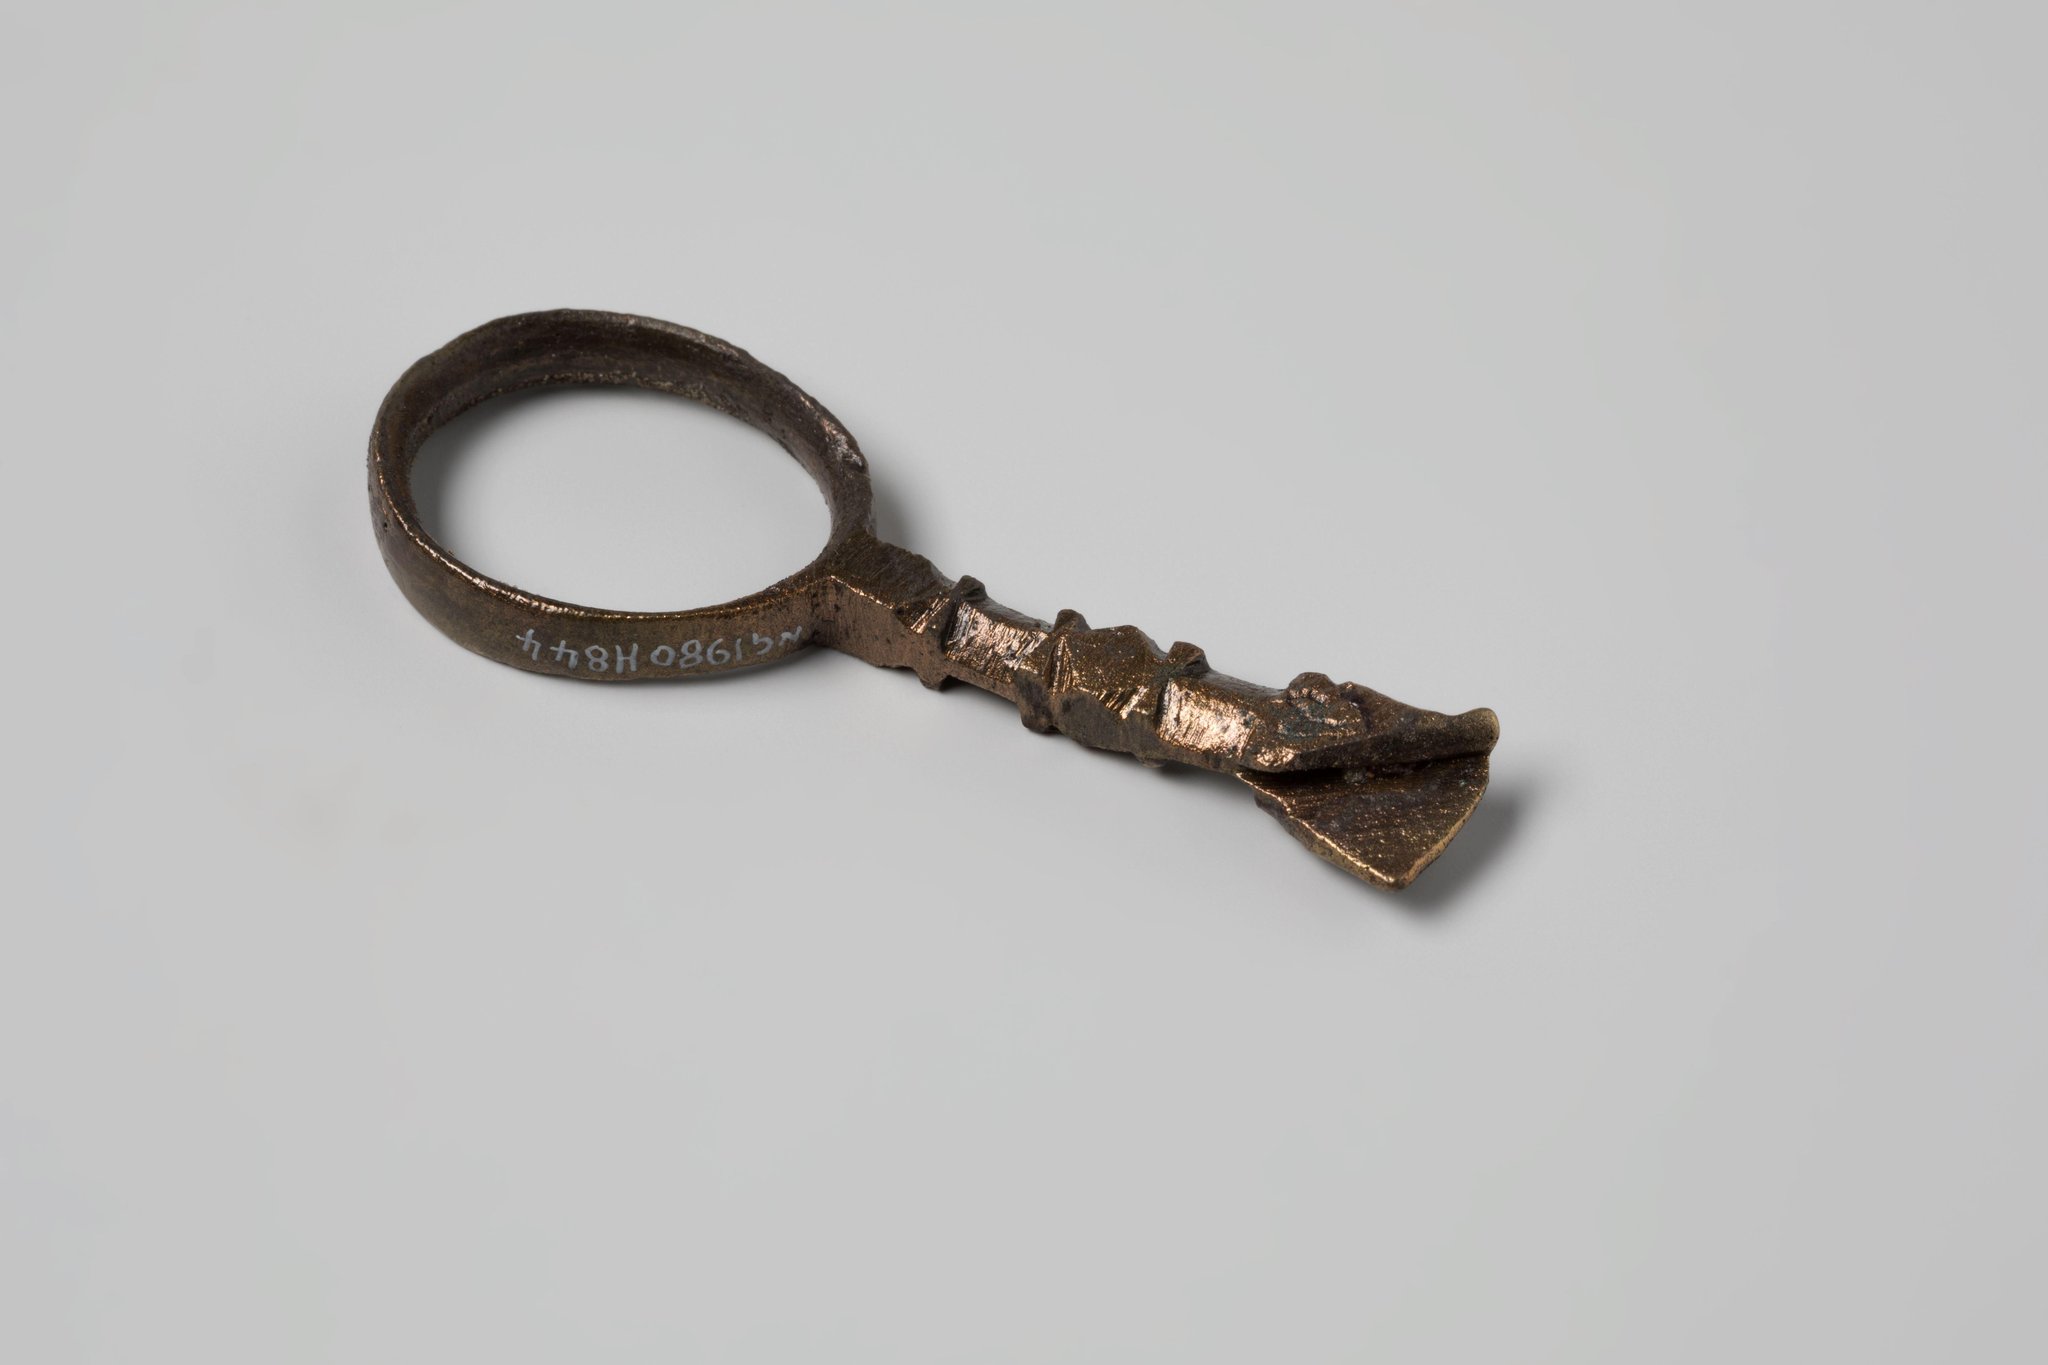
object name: pin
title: Speld uit het wrak van de Oost-Indiëvaarder Hollandia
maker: Anonymous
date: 1700-1743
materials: copper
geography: netherlands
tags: verenigde oostindische compagnie, hollandia (schip), annet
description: Tools and instruments, sewing and sailmaking, pin; fragm of shaft with bow, id. NG 1980-27H844.